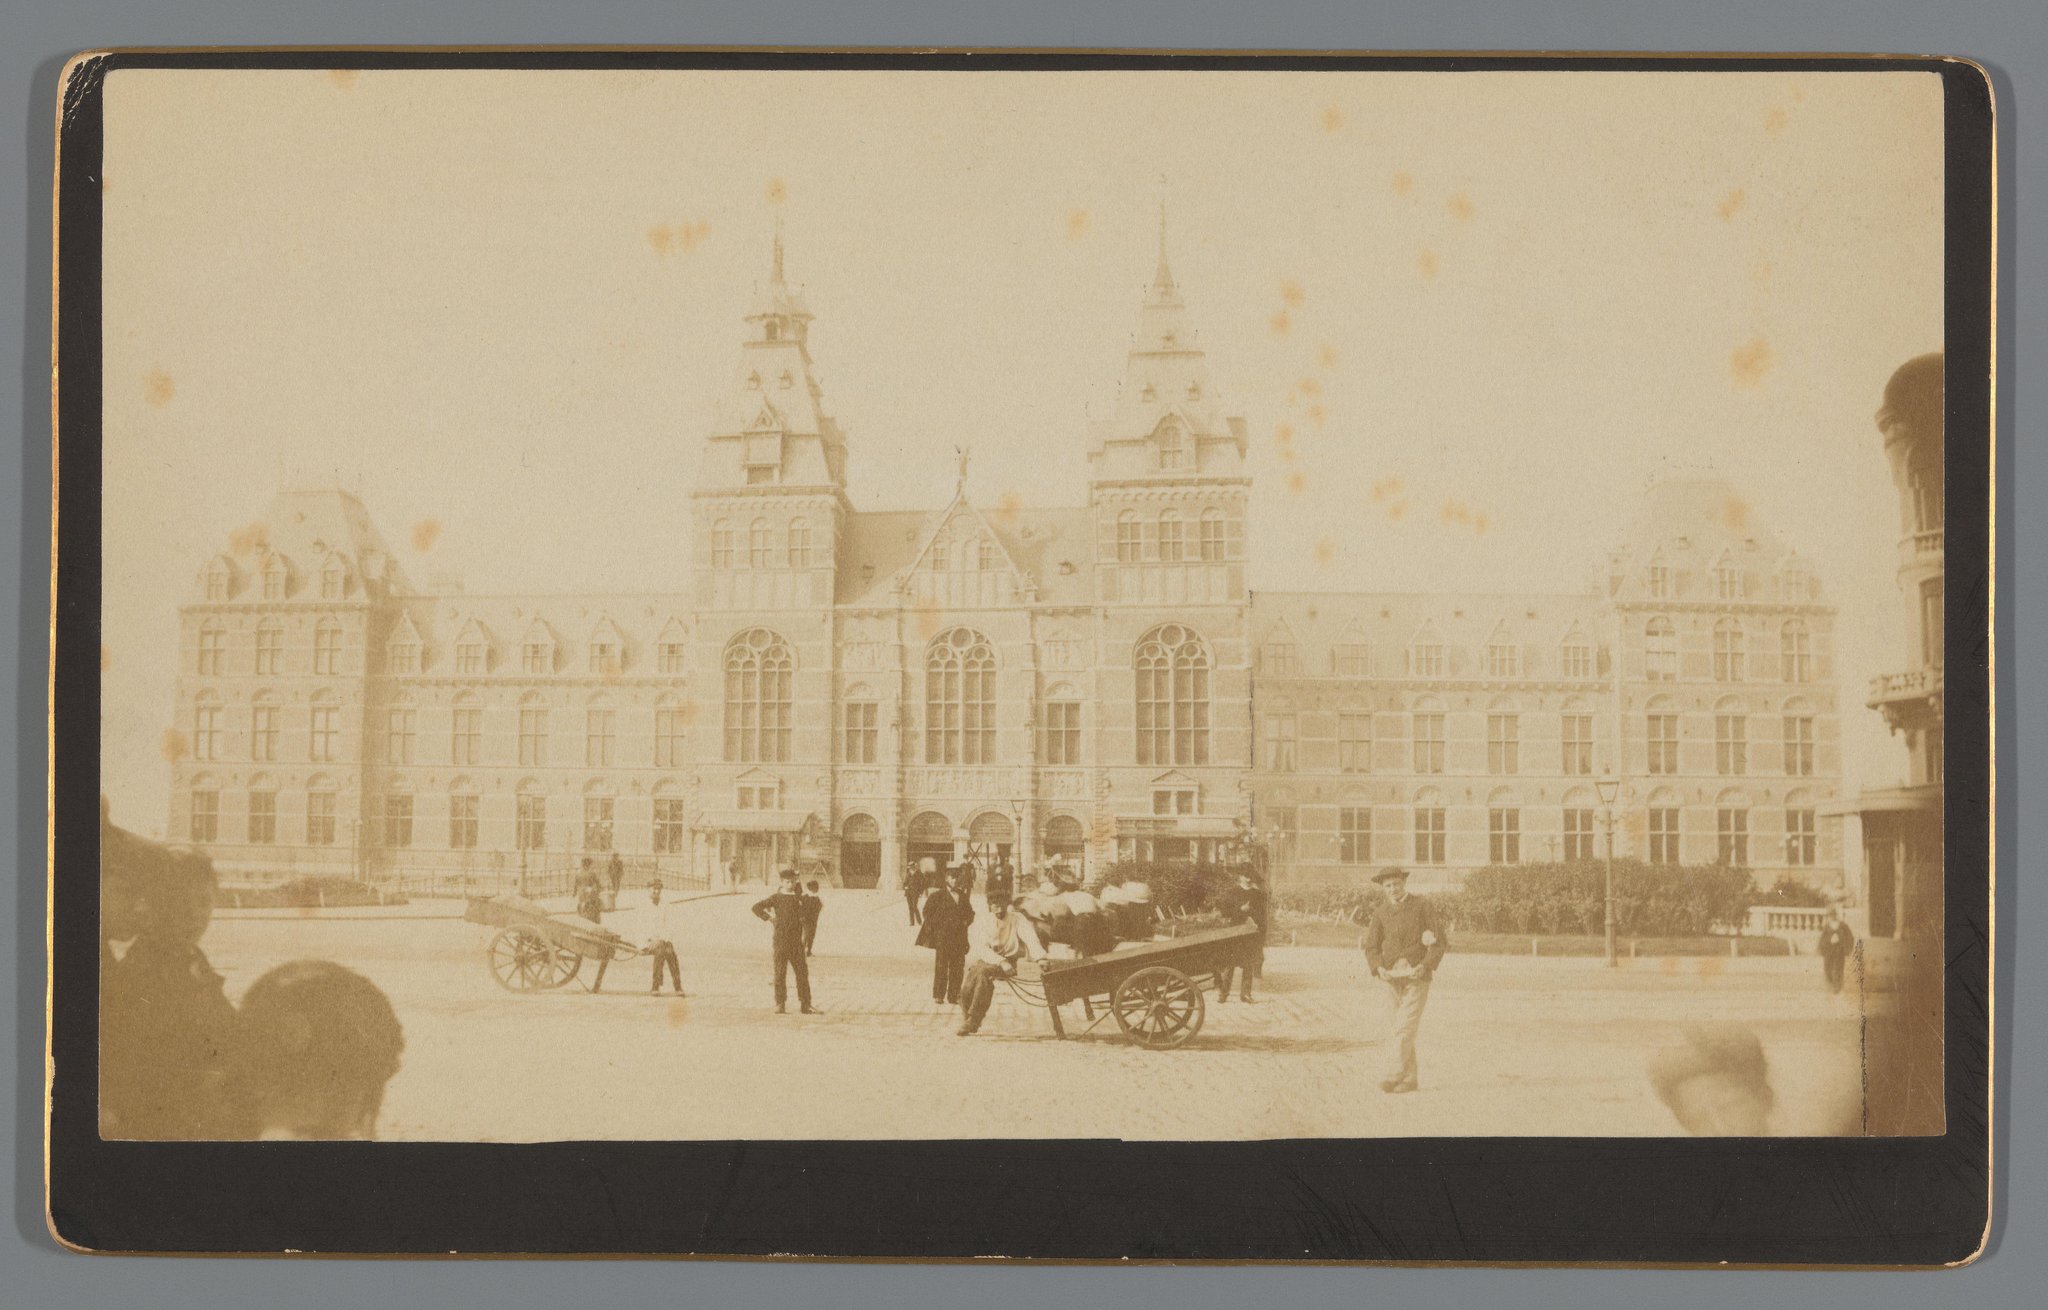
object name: photograph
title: Diner du 13 Juillet 1885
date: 1885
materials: cardboard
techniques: photography, printing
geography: amsterdam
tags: rijksmuseum amsterdam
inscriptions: date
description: Gedrukte menukaart met titel waaronder vijftien gangen, in het Frans en in cursief lopend schrift, op beige ondergrond met rand en aan linker- en rechtbovenzijde decoratie; op de keerzijde een opgeplakte foto van het Rijksmuseum, met op de voorgrond enkele poserende personen, van wie twee met een handkar. Vermoedelijk vond het diner plaats in Maison Couturier aan de Keizersgracht.